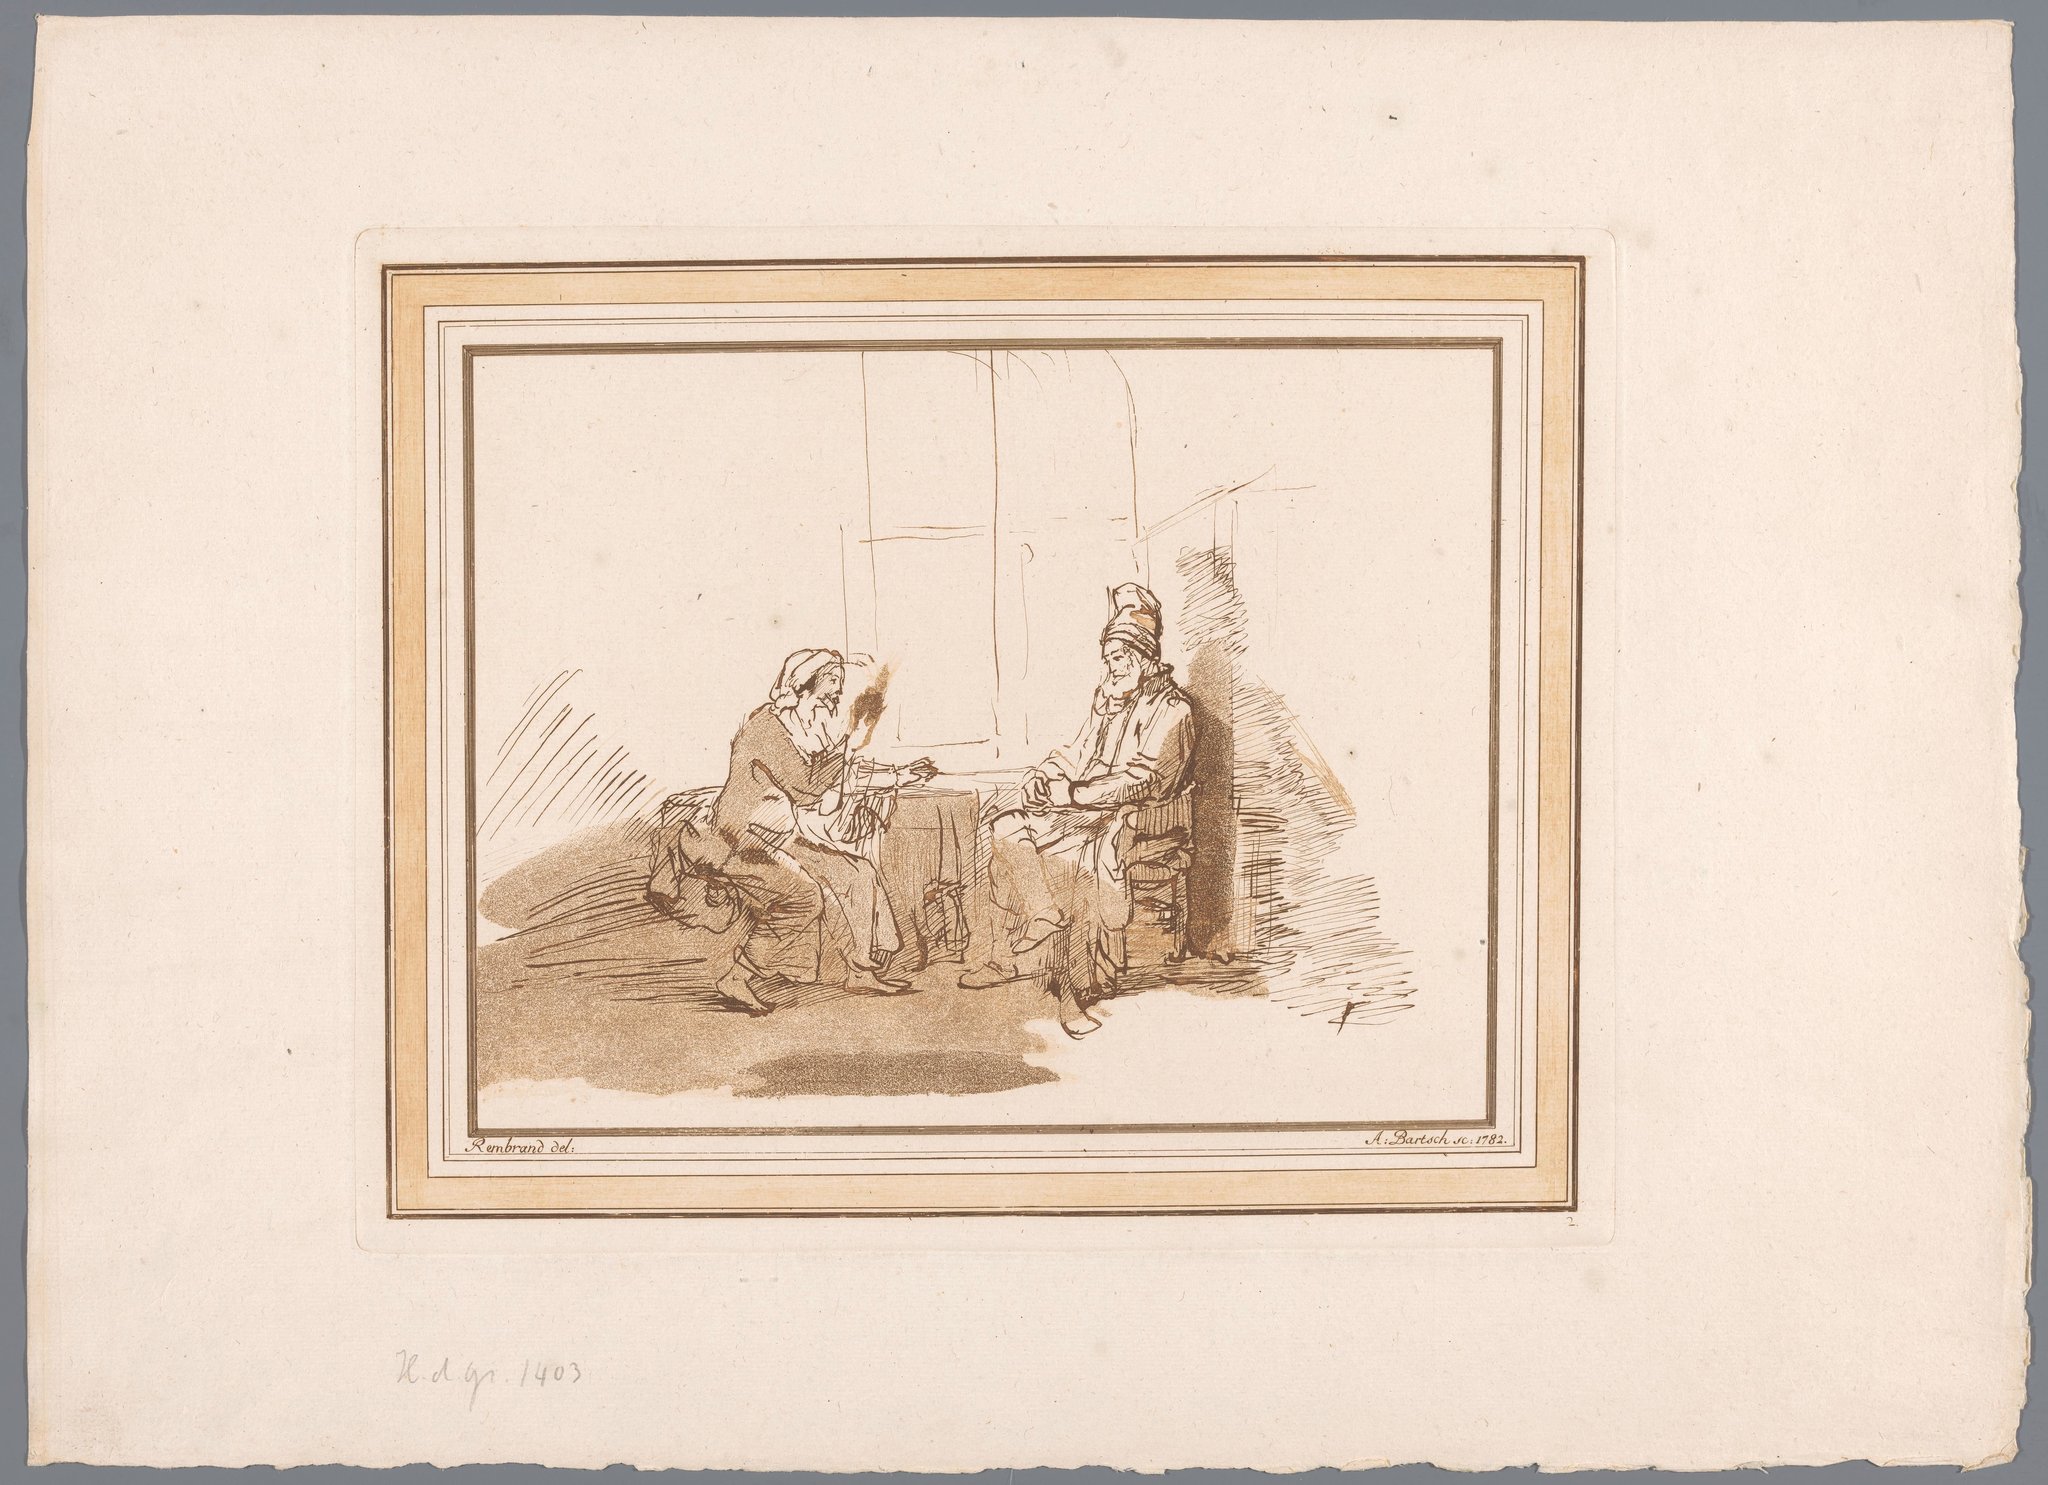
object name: print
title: Christus in gesprek met Nikodemus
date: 1782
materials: paper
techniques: aquatint, etching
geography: vienna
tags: christ talking with nicodemus at night (john 3:1-21)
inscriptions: collector's mark: Lugt 2228